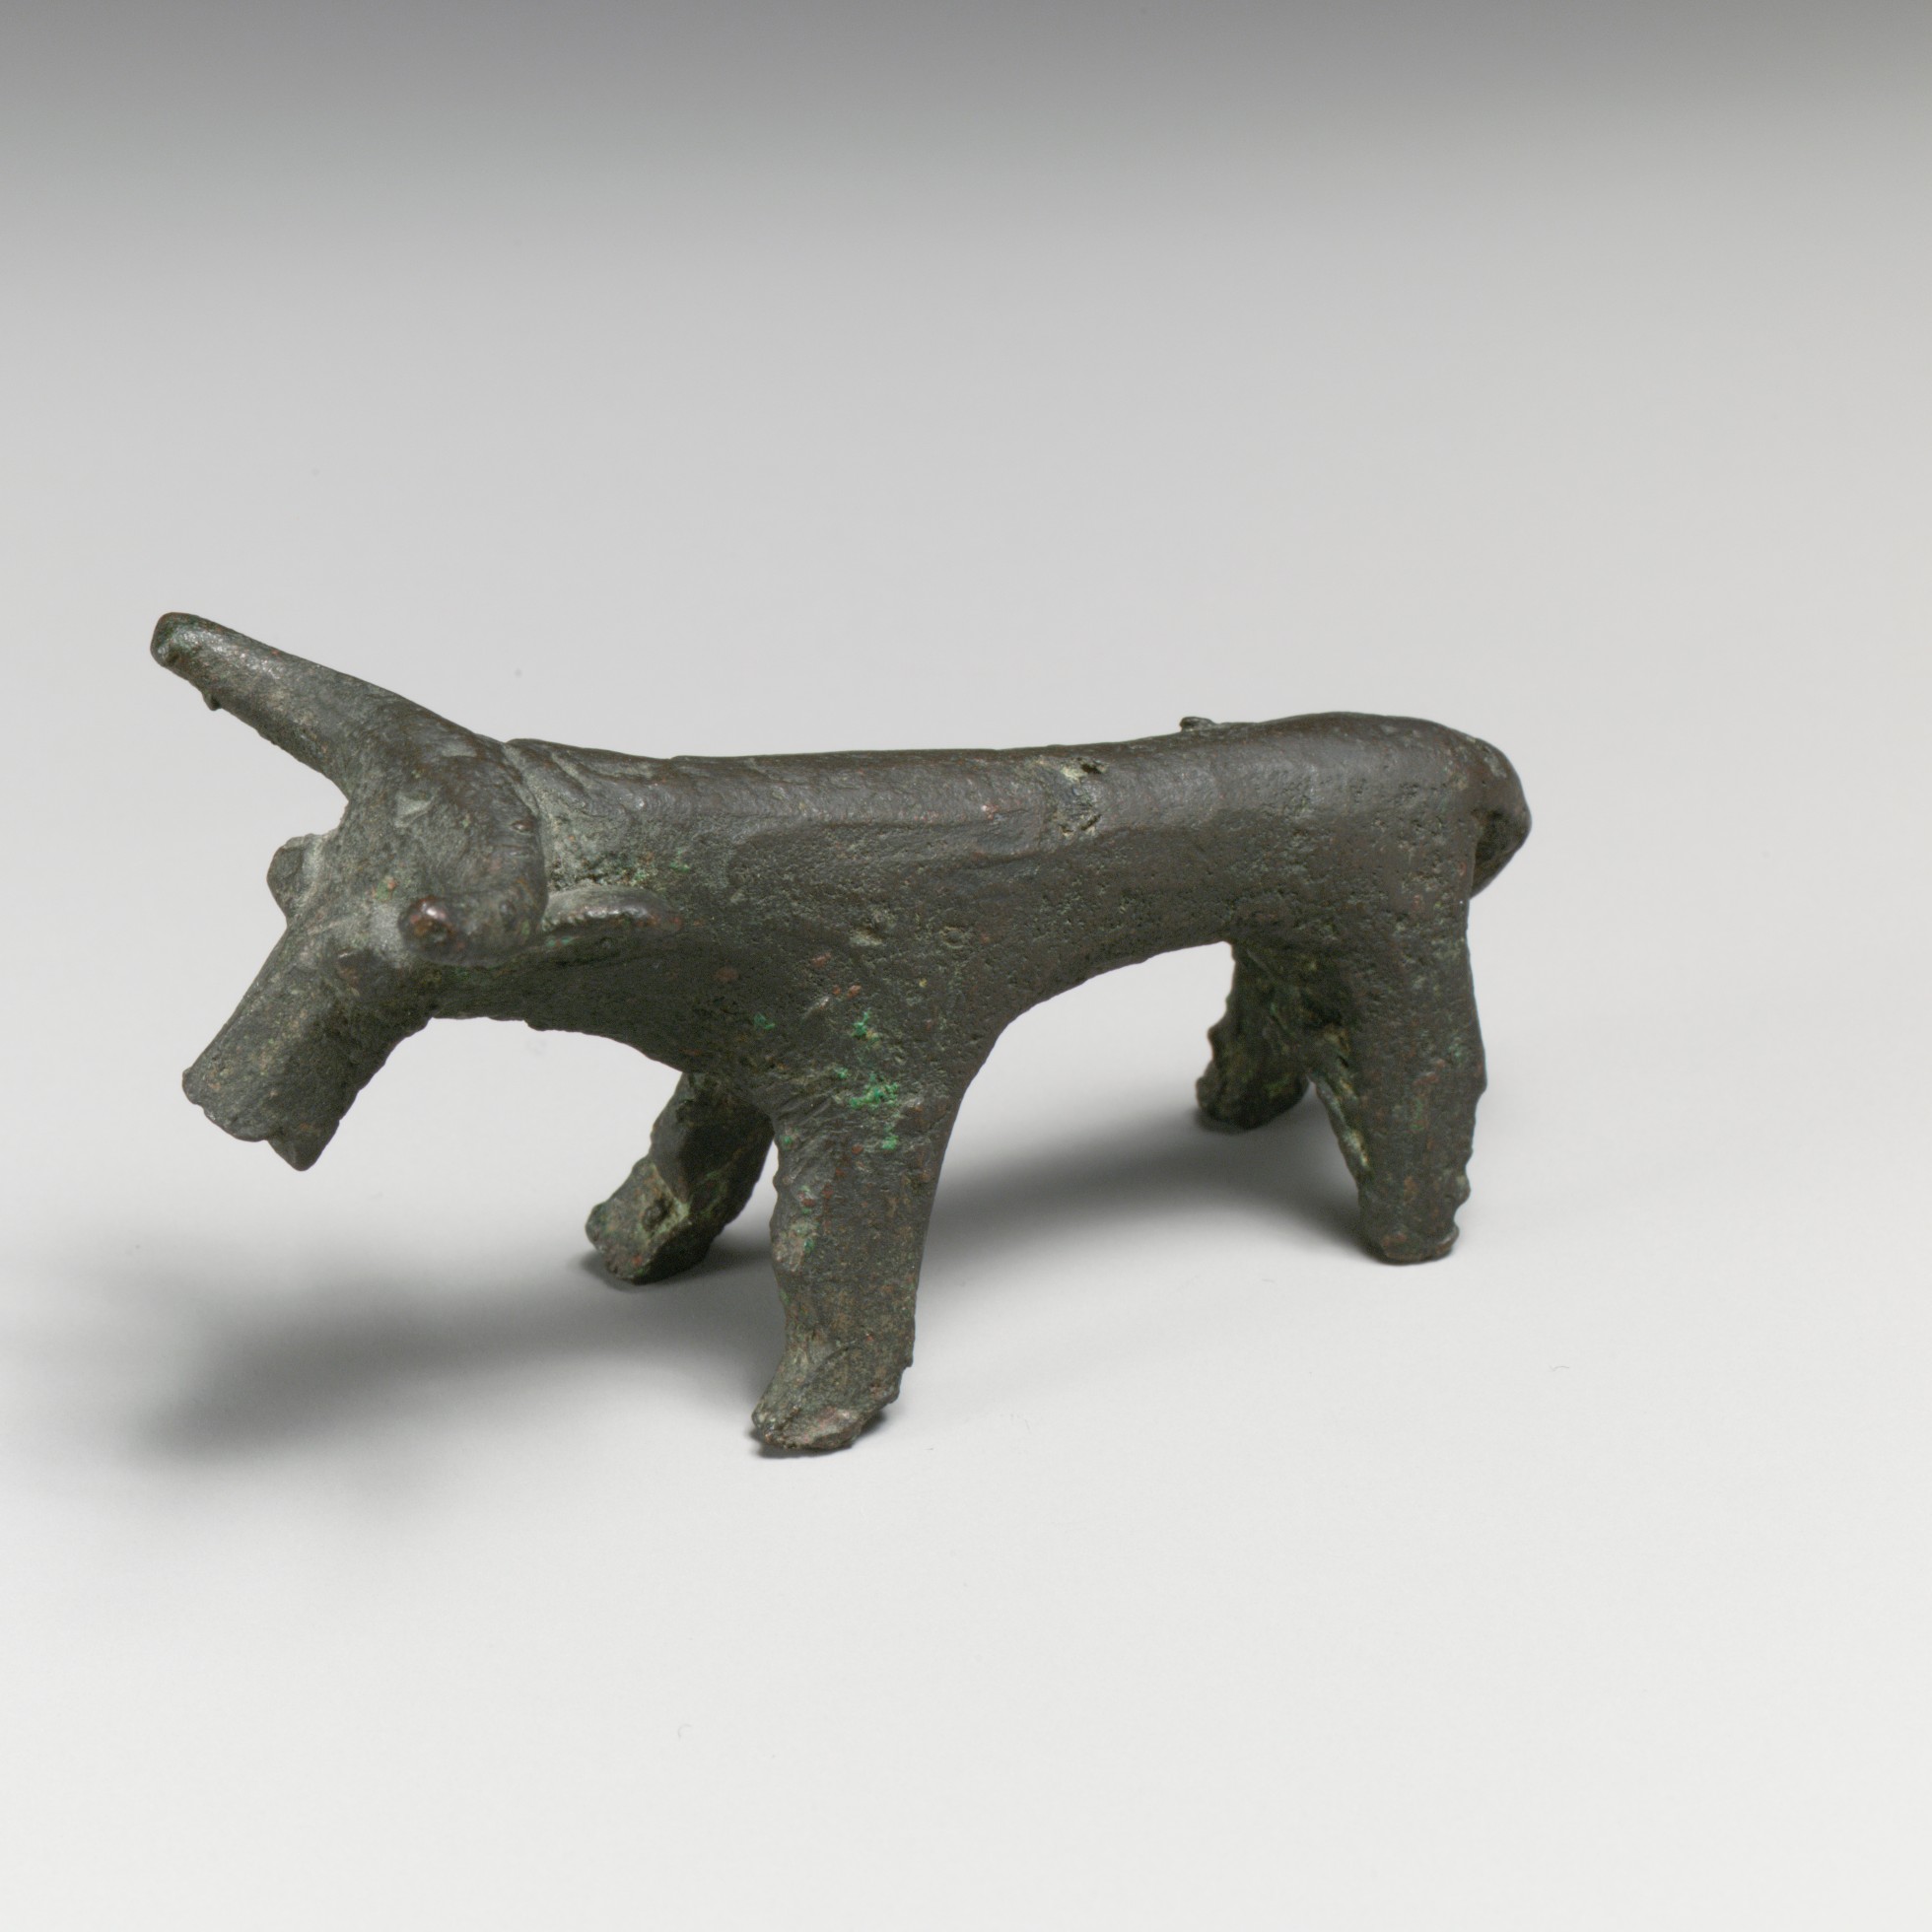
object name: statuette of a bull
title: Bronze statuette of a bull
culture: greek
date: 700-601 BCE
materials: bronze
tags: bulls